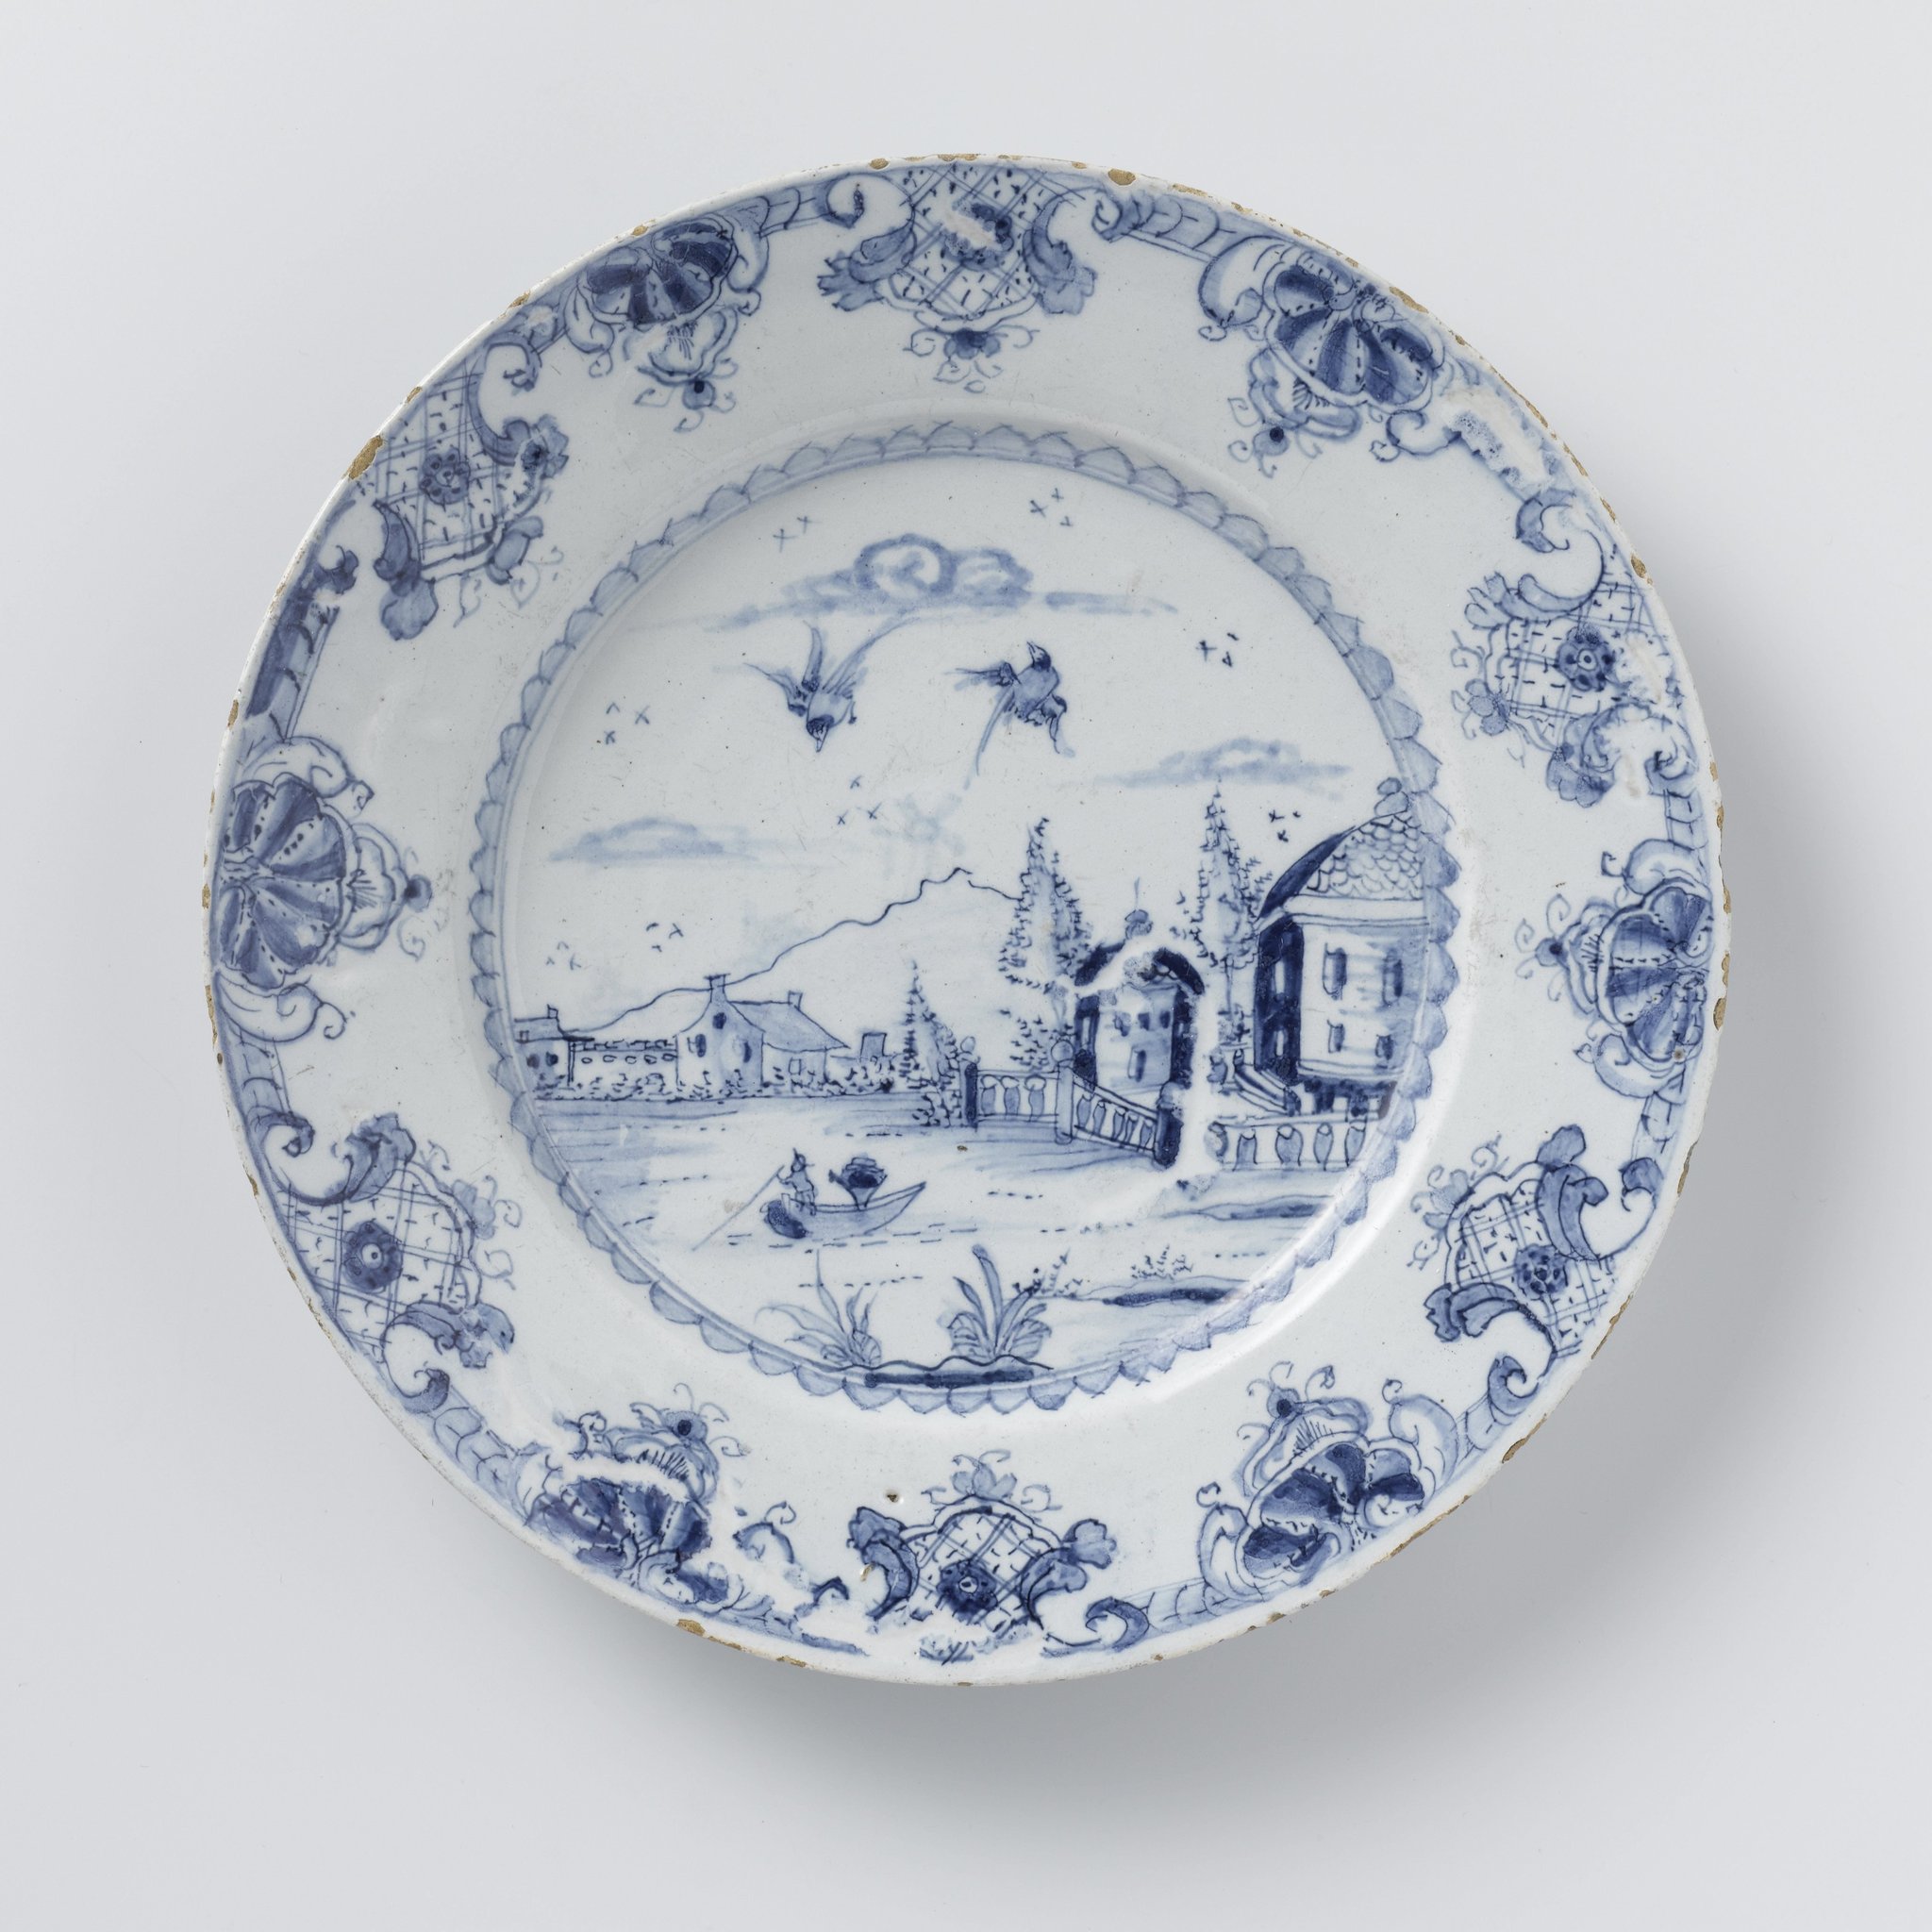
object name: plate dish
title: Bord van faience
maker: Anonymous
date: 1750-1775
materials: faience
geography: delft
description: Bord van faience. Blauw beschilderd met een Hollands landschap met water.